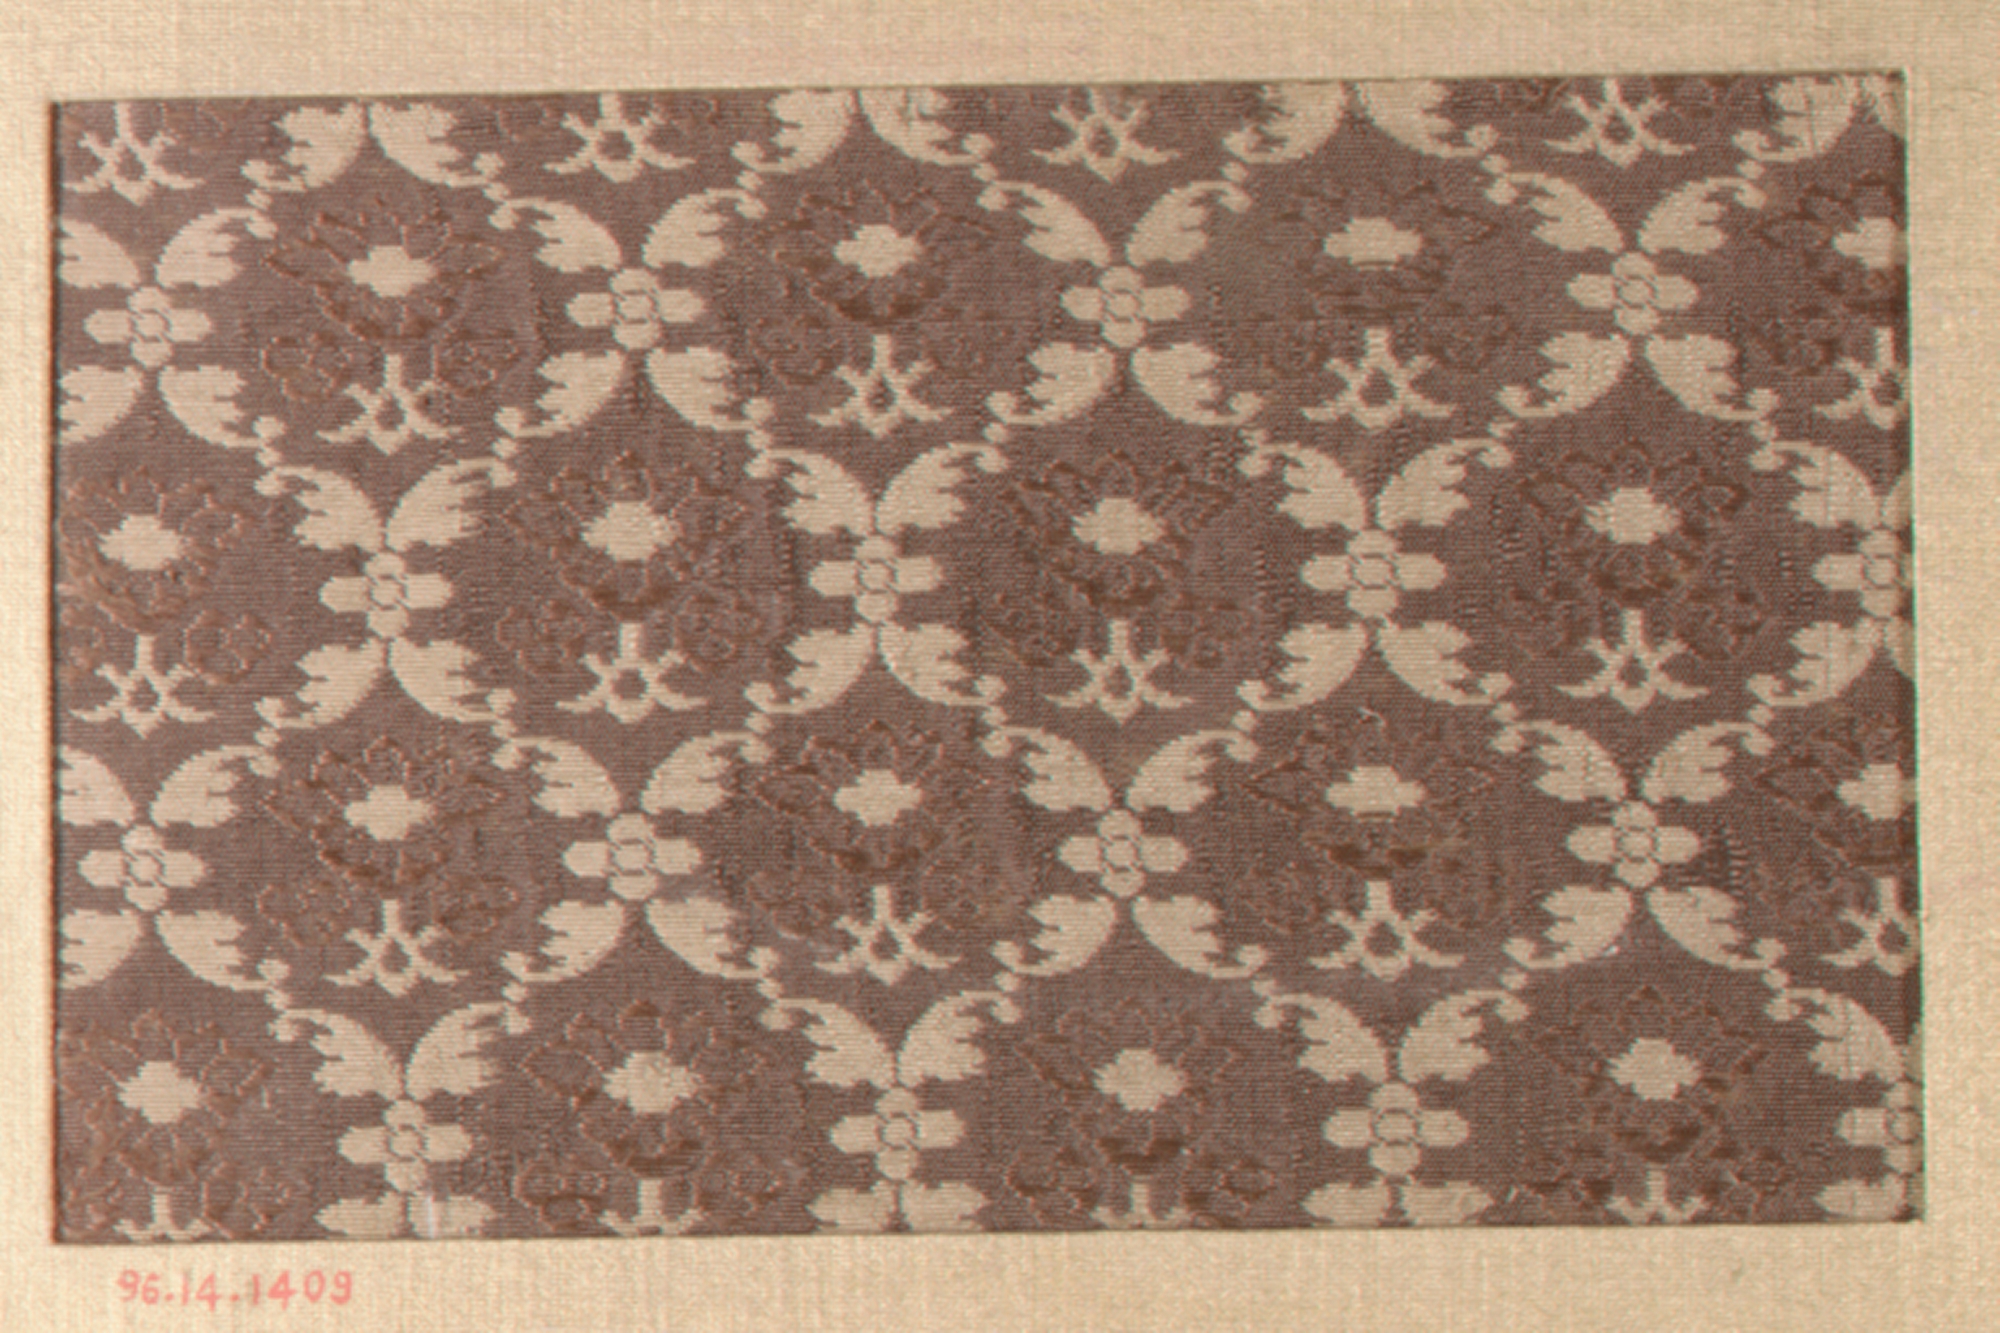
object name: piece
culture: japanese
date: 1701-1900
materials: silk